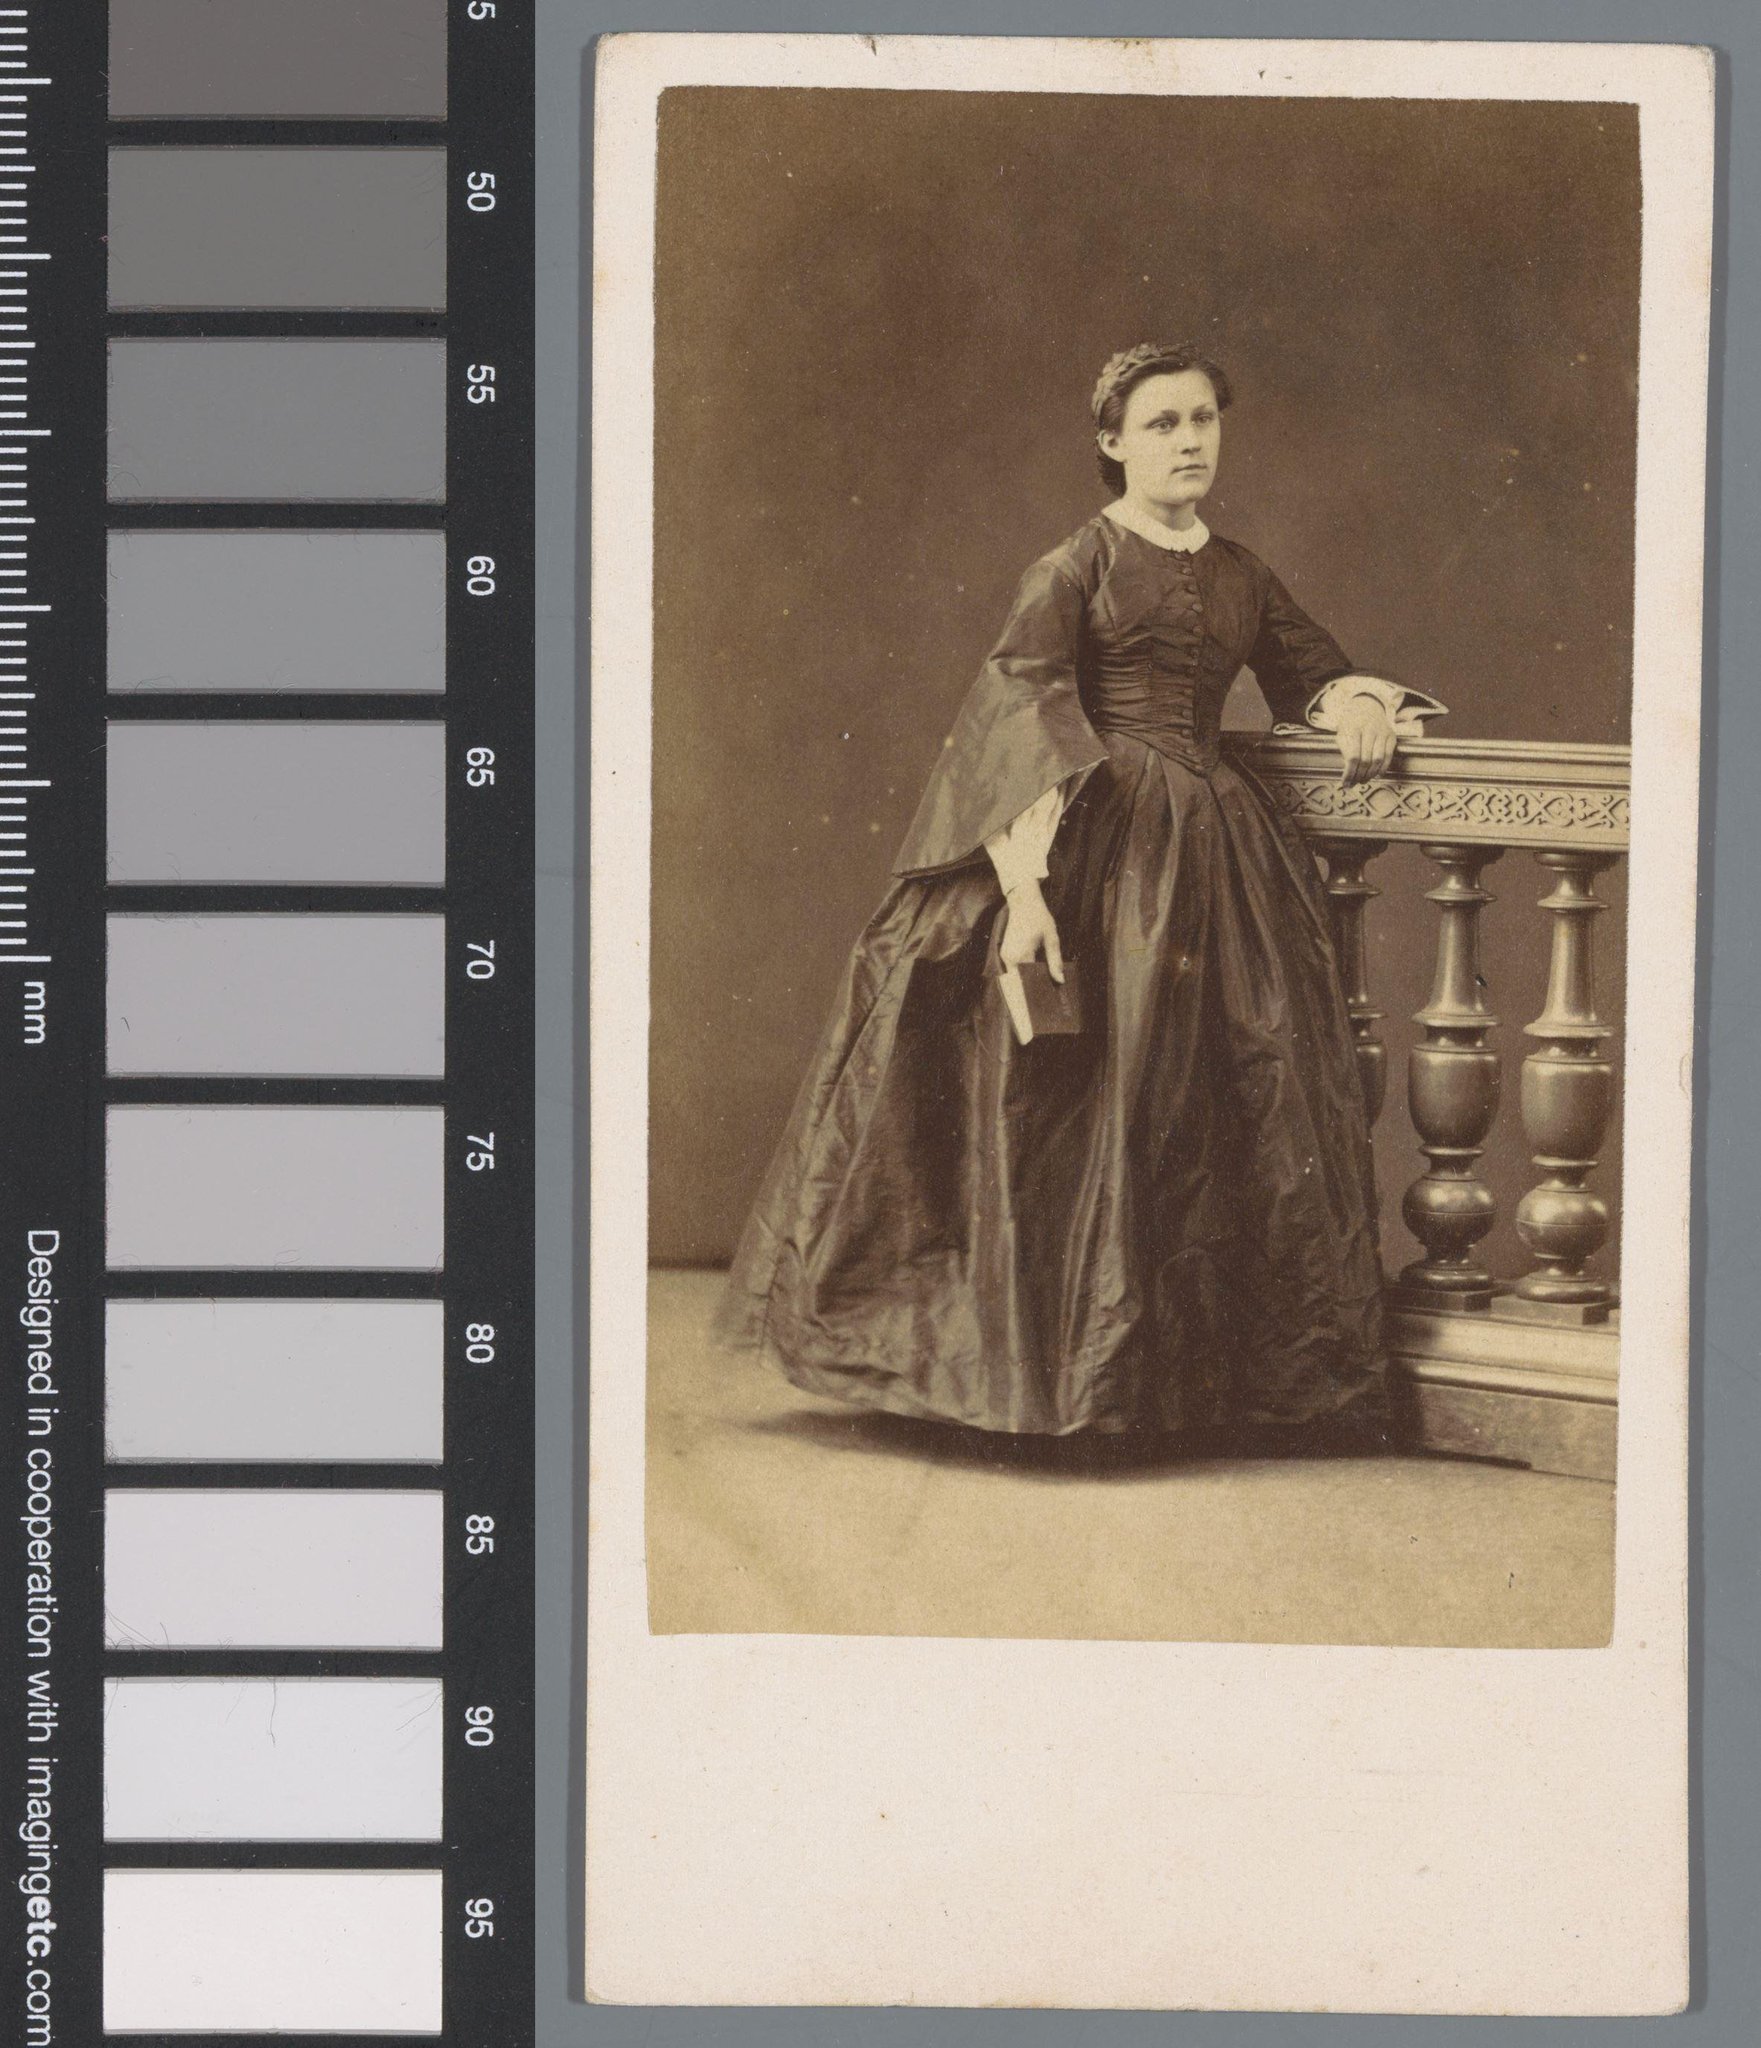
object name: photograph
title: Portret van een onbekende vrouw met boek bij balustrade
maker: félix-jacques moulin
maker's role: fotograaf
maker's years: 1802-1879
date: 1855-1879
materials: cardboard, paper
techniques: albumen print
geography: paris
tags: adult woman, anonymous historical person portrayed, paris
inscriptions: inscription: ‘Atelier Photographique/ Moulin/ Rue Richer, 23, Paris’